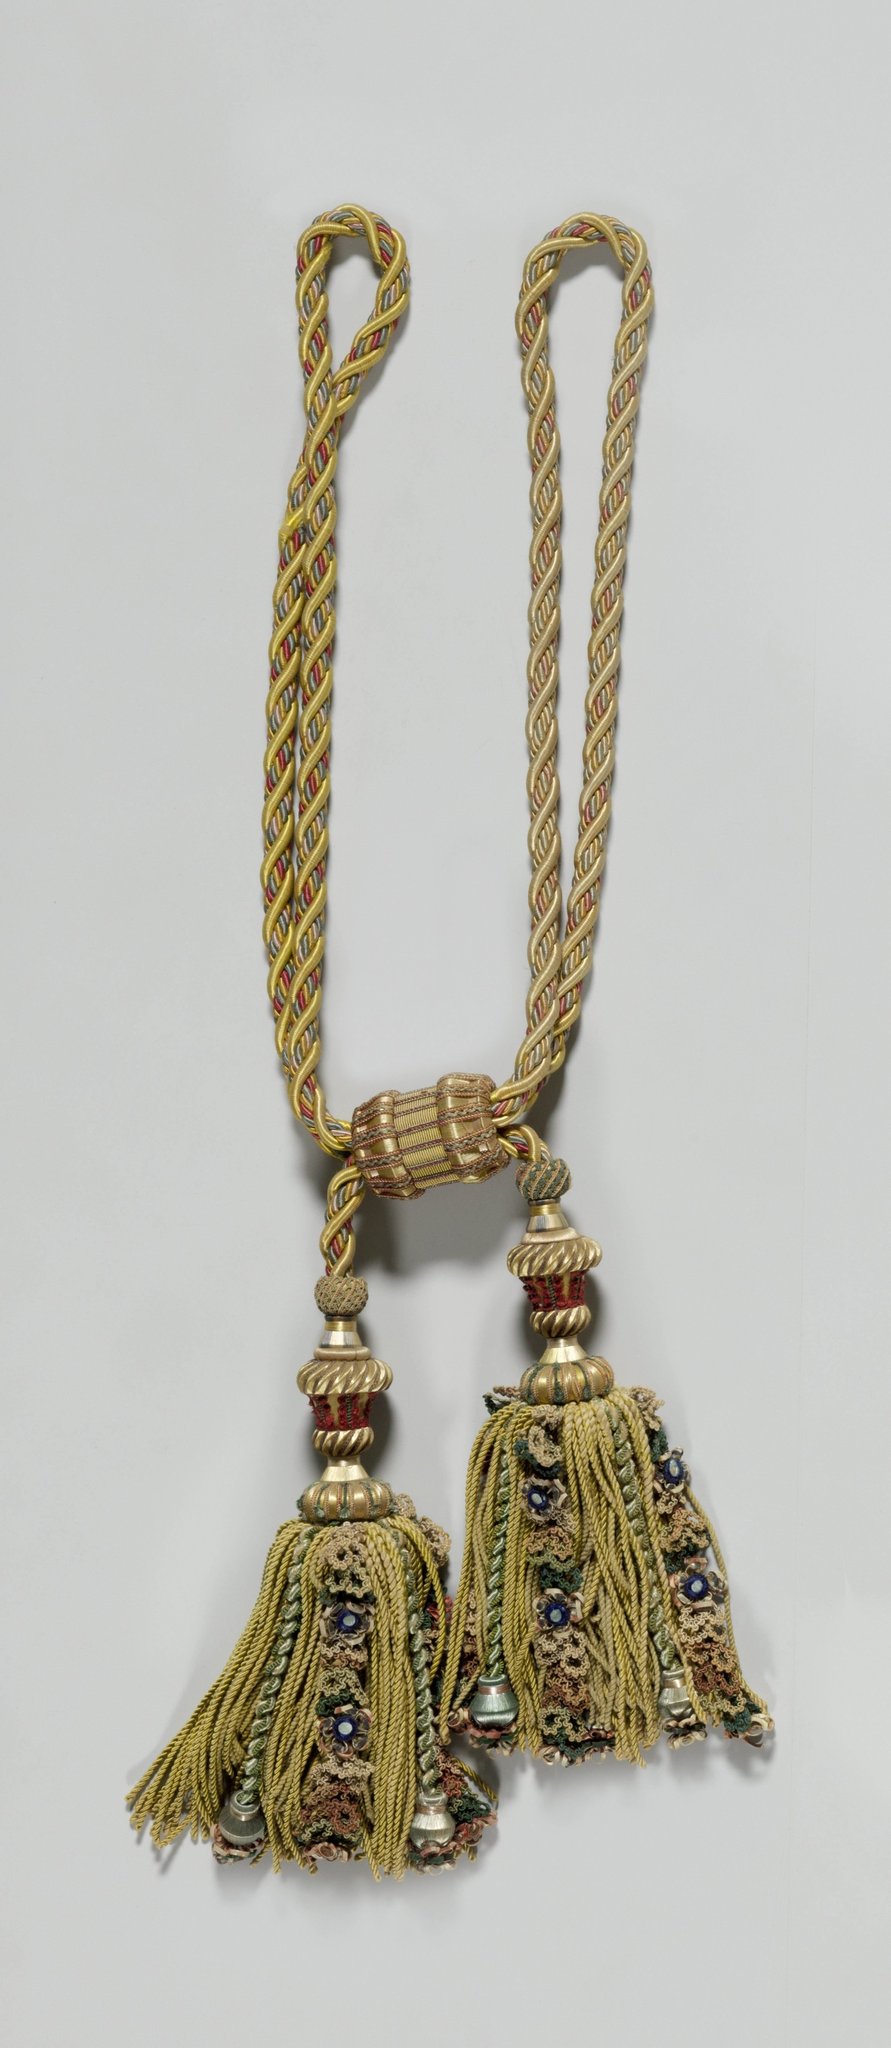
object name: tieback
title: Embrasse behorend bij een stel gordijnen met bloemdessin op geel fond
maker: carel hubertus windt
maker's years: 1804-1860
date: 1850-1860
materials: silk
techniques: lampas, weave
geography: the hague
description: Embrasse behorend bij een stel gordijnen van zijde met bloemdessin op geel fond, afkomstig uit de kleine danszaal van Paleis Noordeinde.